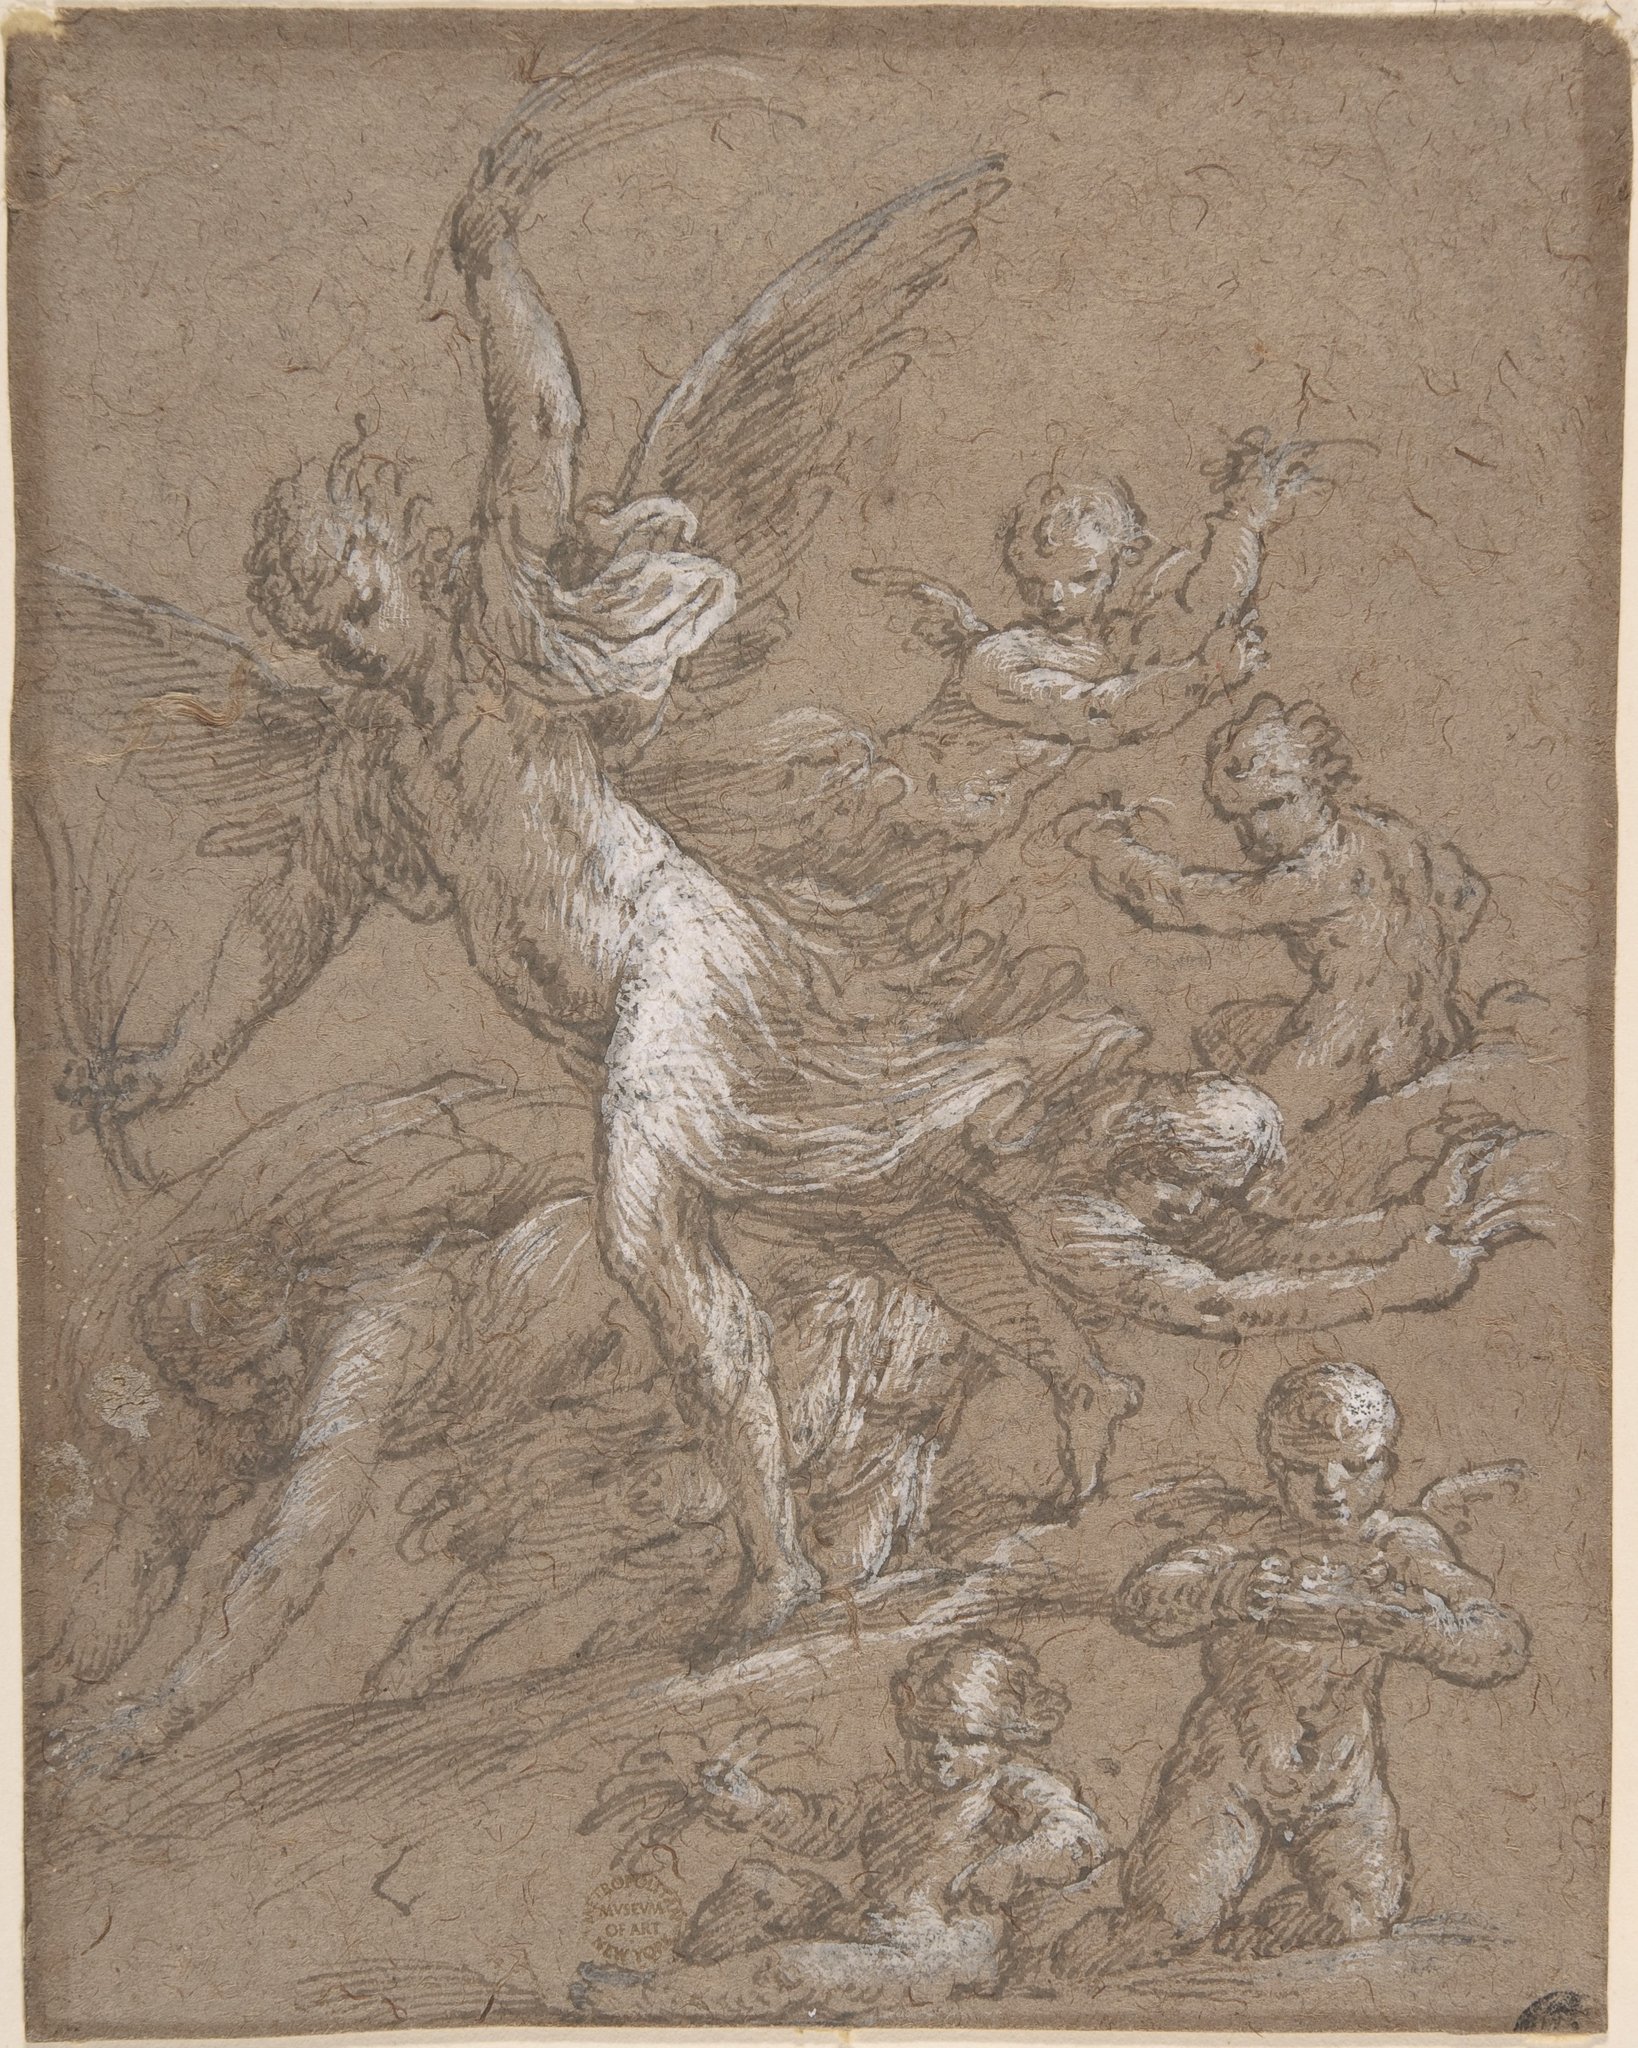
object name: drawing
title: Angels and Putti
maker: anonymous, italian, roman-bolognese, 17th century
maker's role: artist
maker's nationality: italian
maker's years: 1600-1700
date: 1601-1700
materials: chalk, gouache, ink, paper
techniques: highlighting, pen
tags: angels